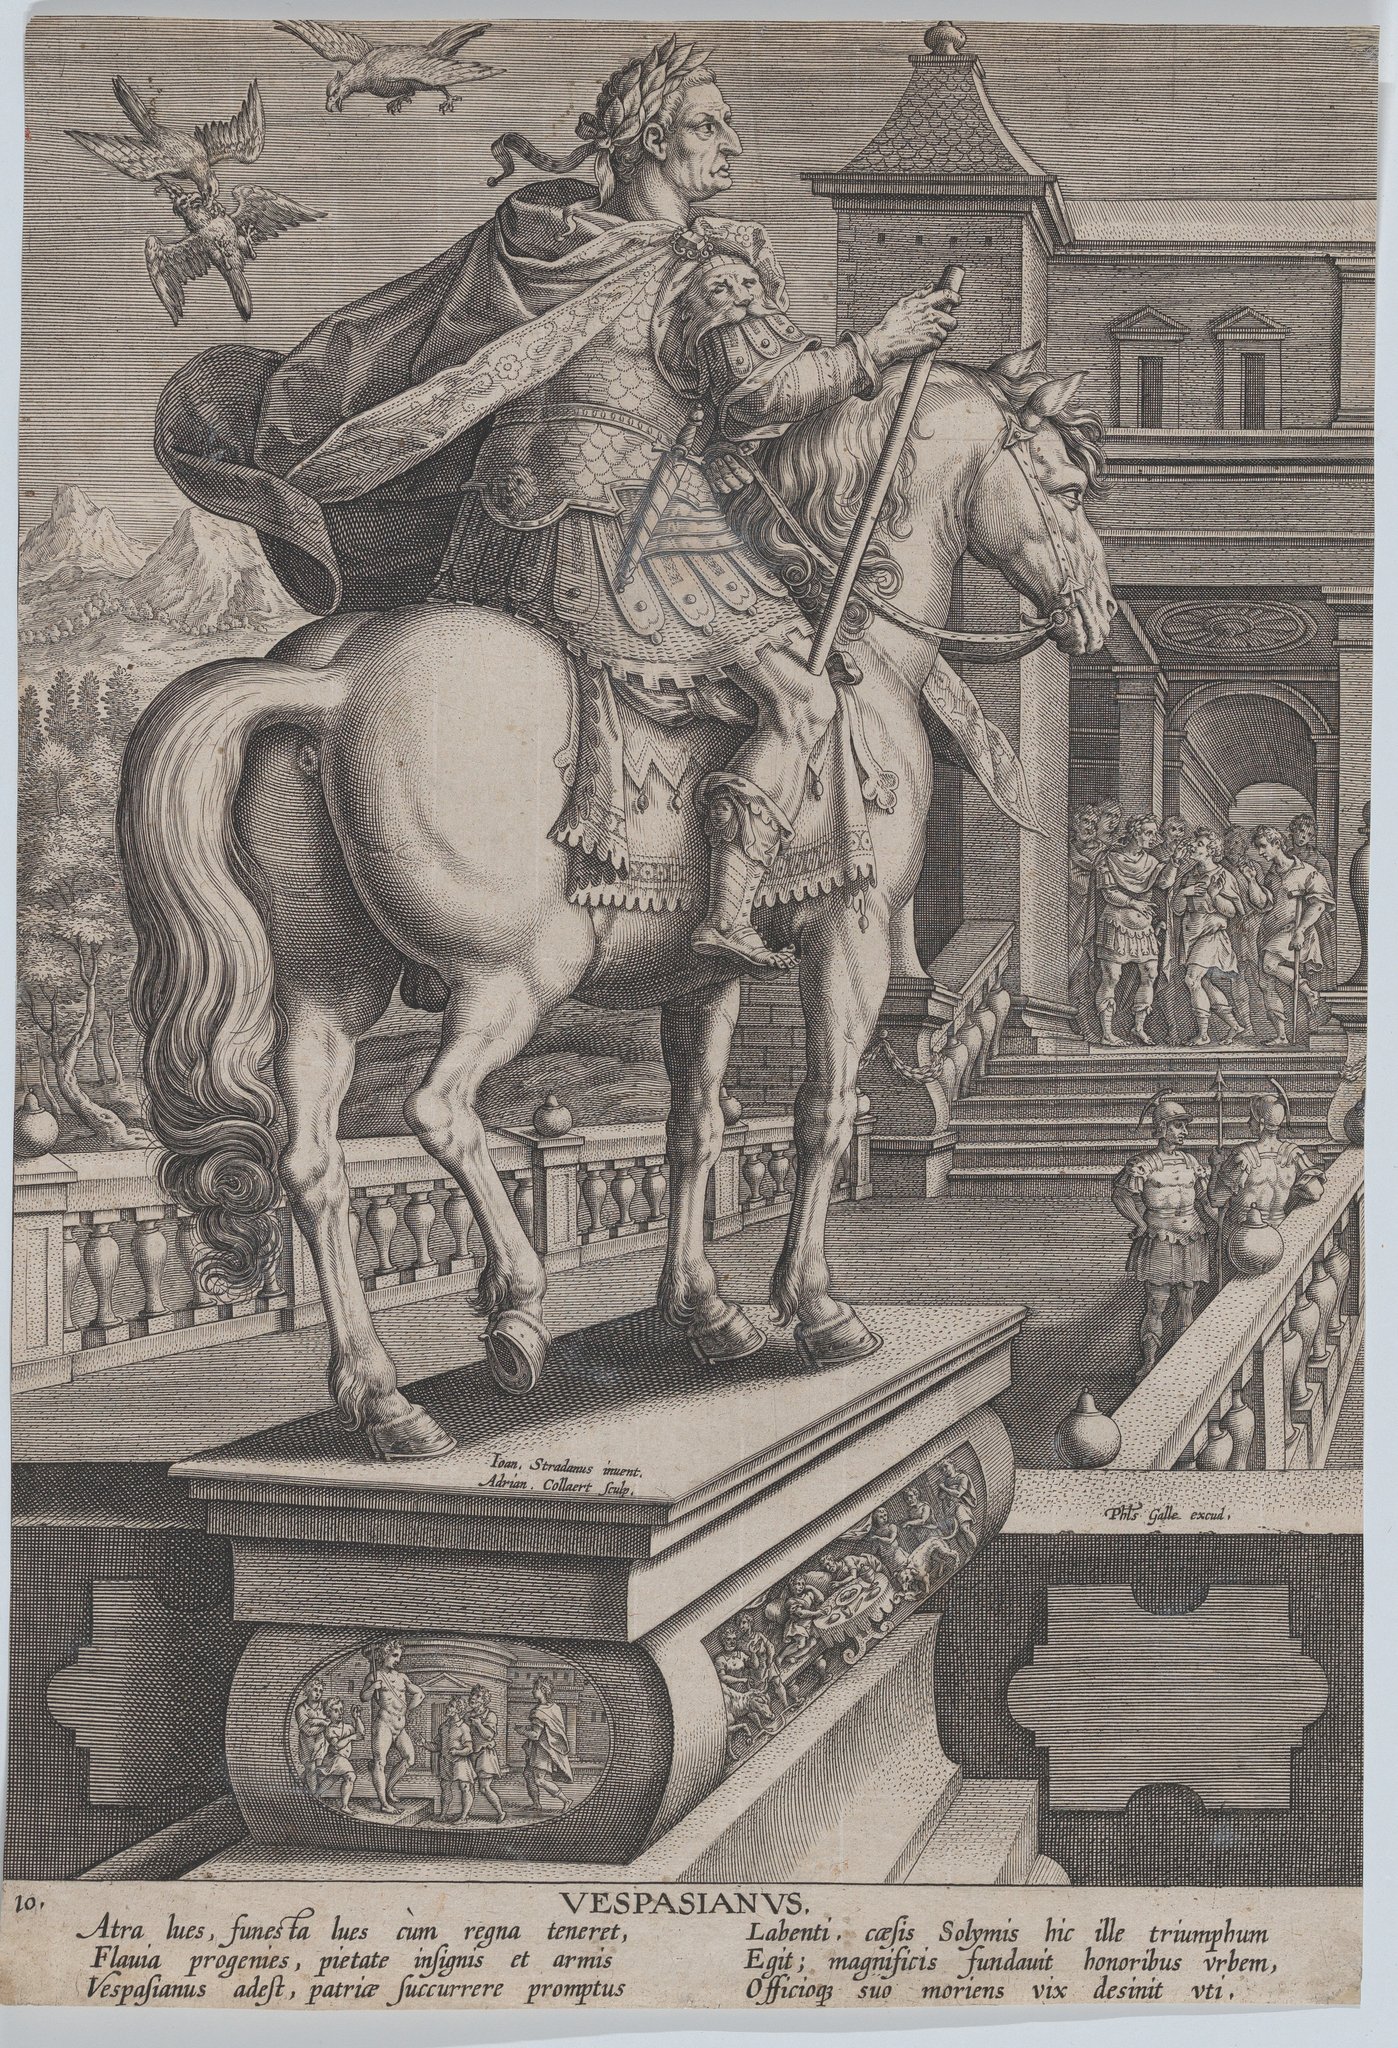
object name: print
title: Plate 10: equestrian statue of Vespasian, seen from behind, three birds at upper right with one attacking another, from 'Roman Emperors on Horseback'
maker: adriaen collaert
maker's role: artist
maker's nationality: netherlandish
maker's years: 1560-1618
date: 1587-1589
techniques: engraving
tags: birds,men,horses